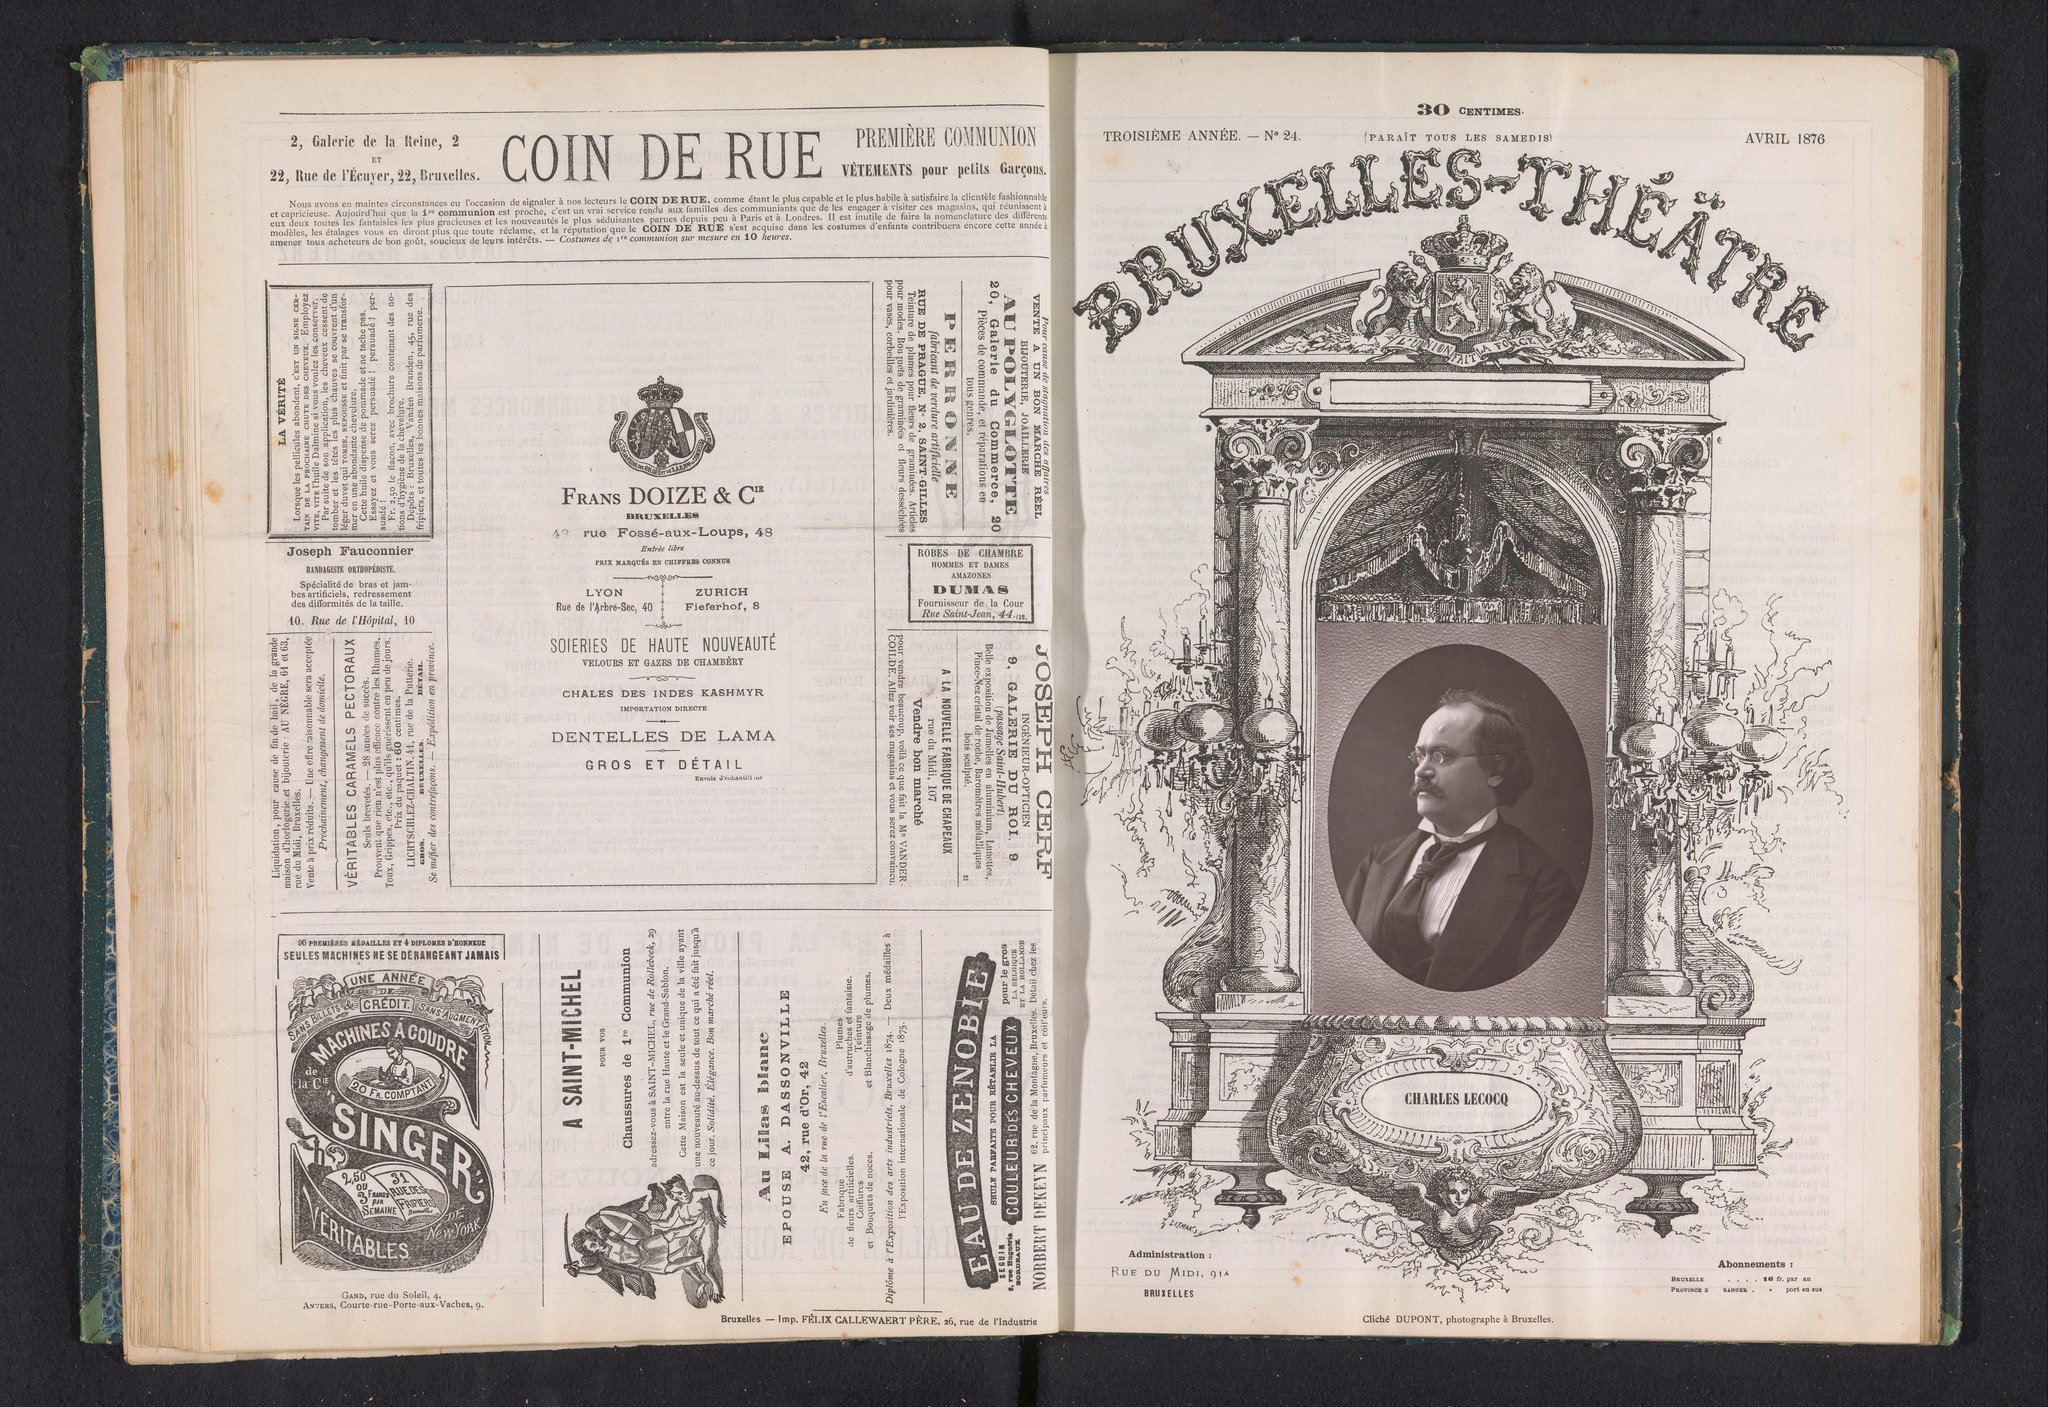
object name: page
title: Portret van Charles Lecocq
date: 1871-1876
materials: paper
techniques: woodburytype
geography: brussels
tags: composer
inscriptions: number: ‘No 24.’